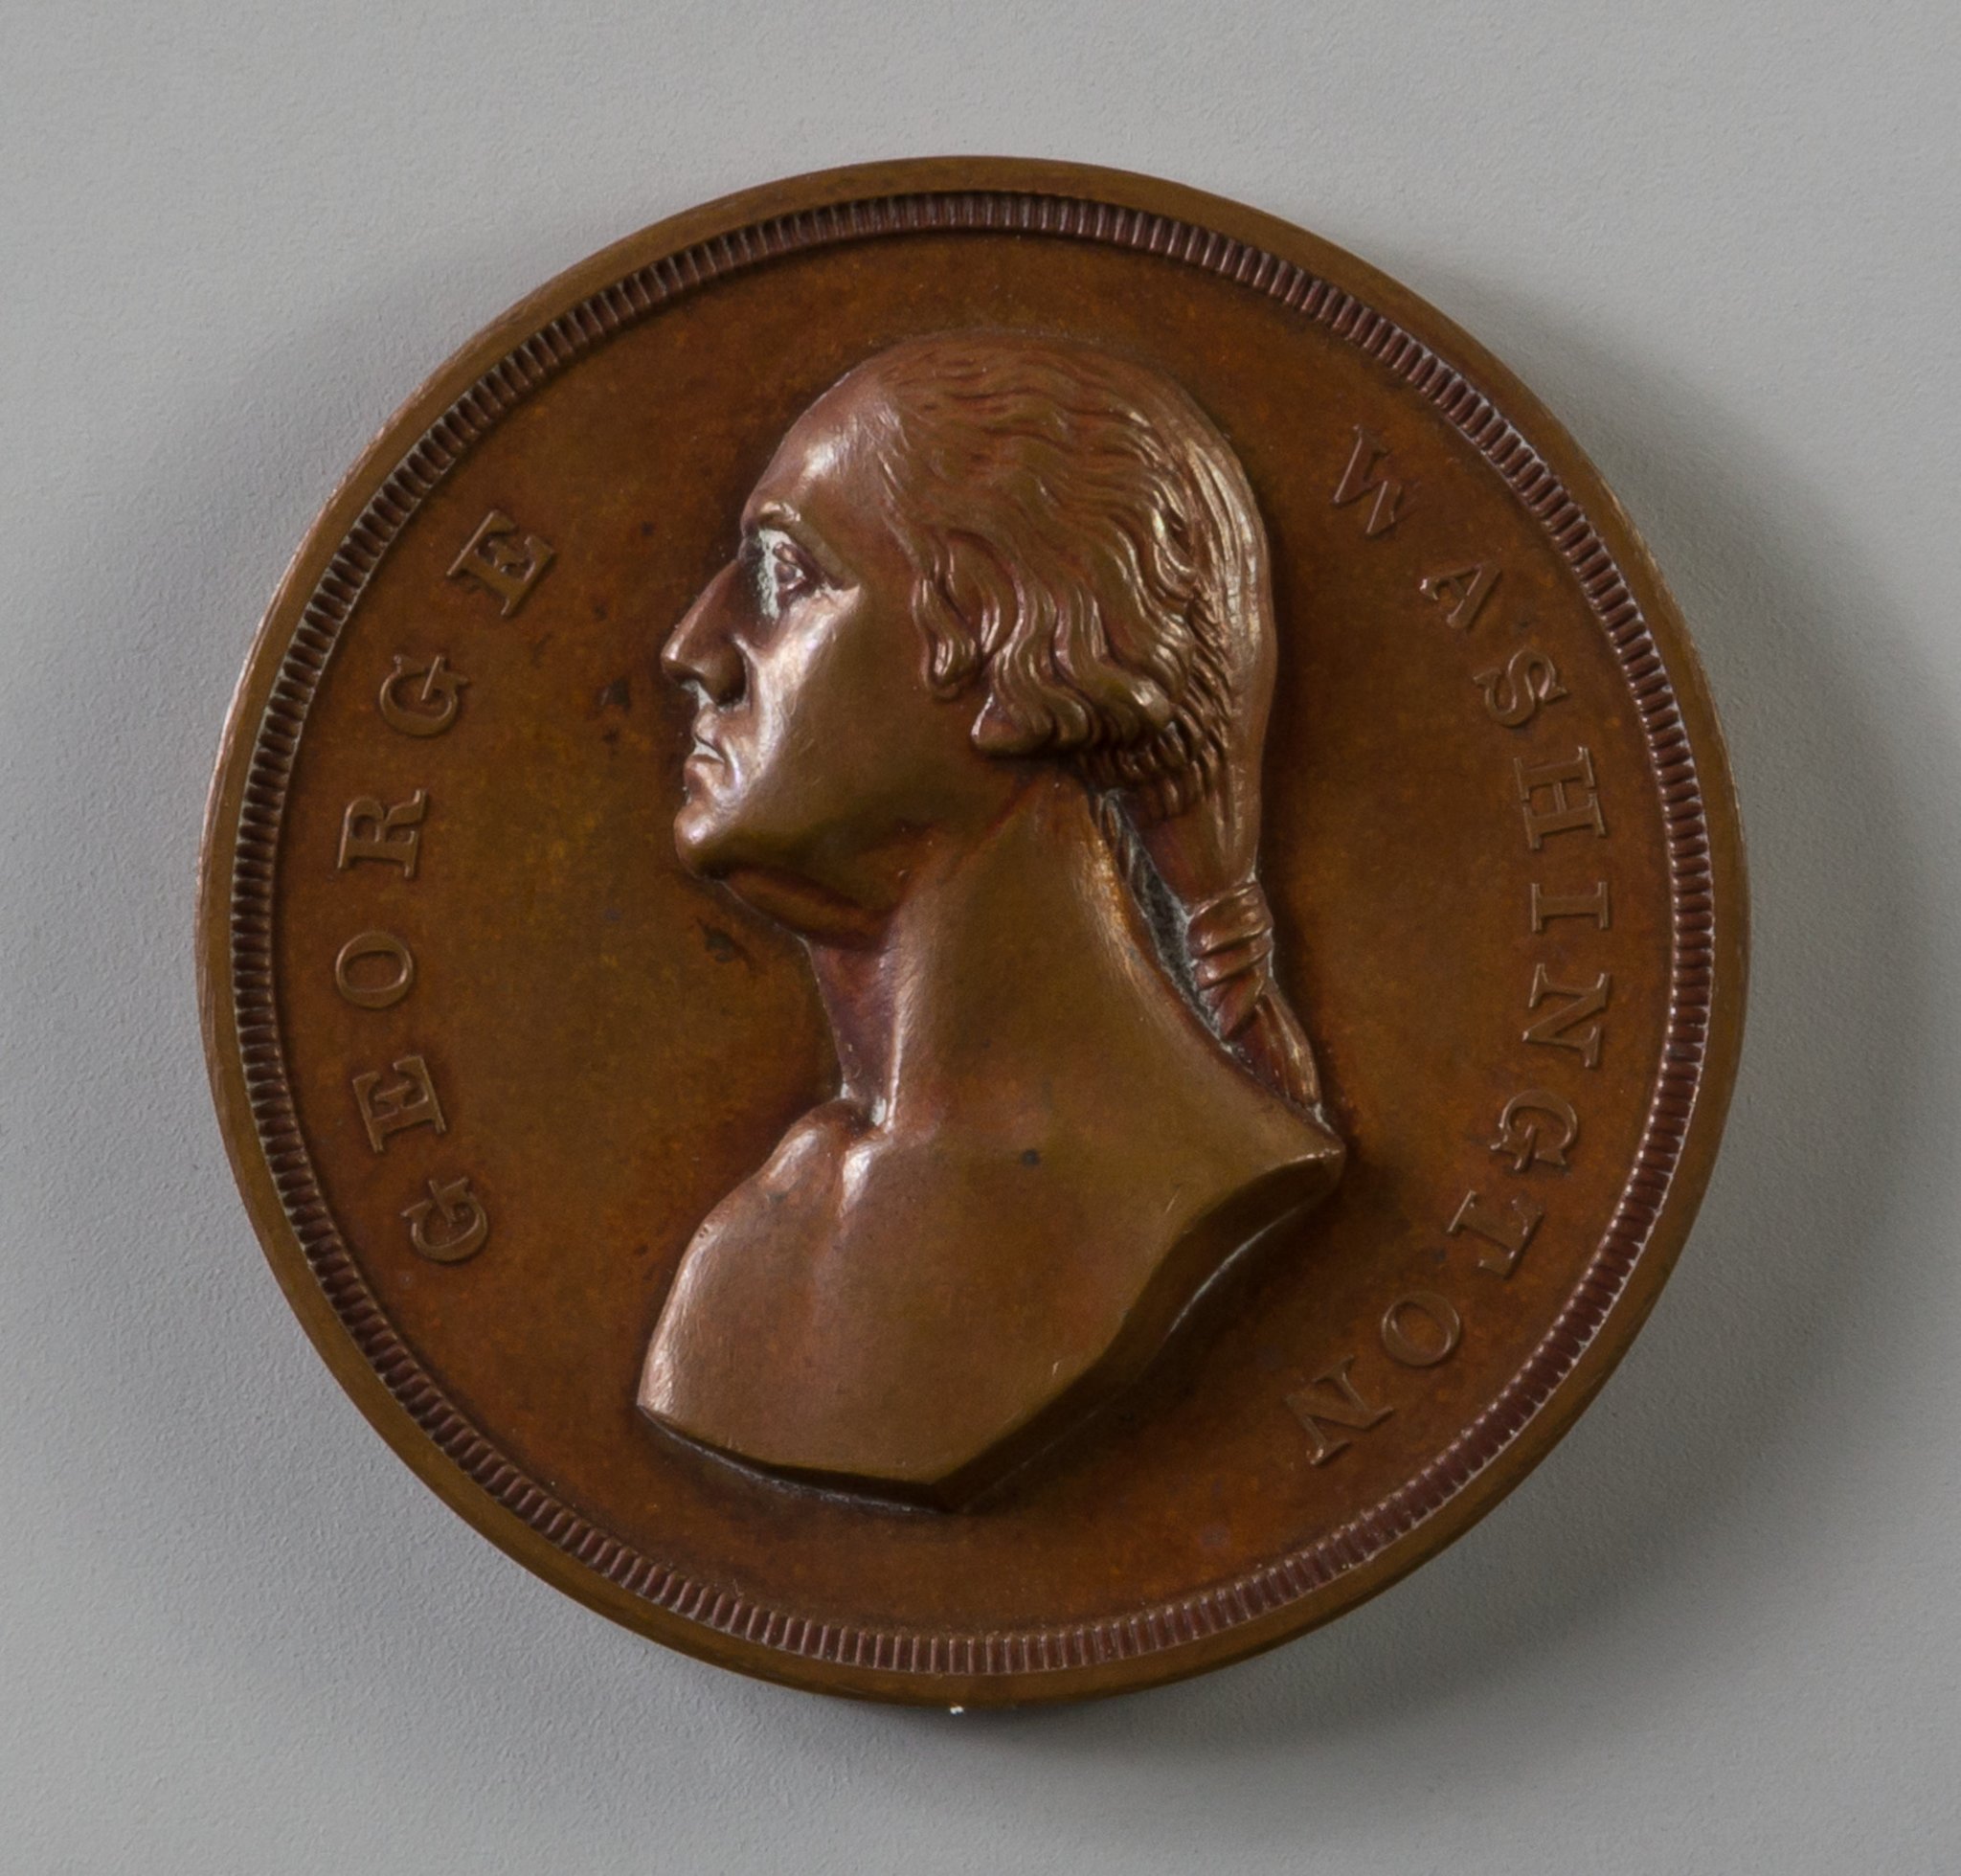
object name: medal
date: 1791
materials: bronze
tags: george washington,profiles